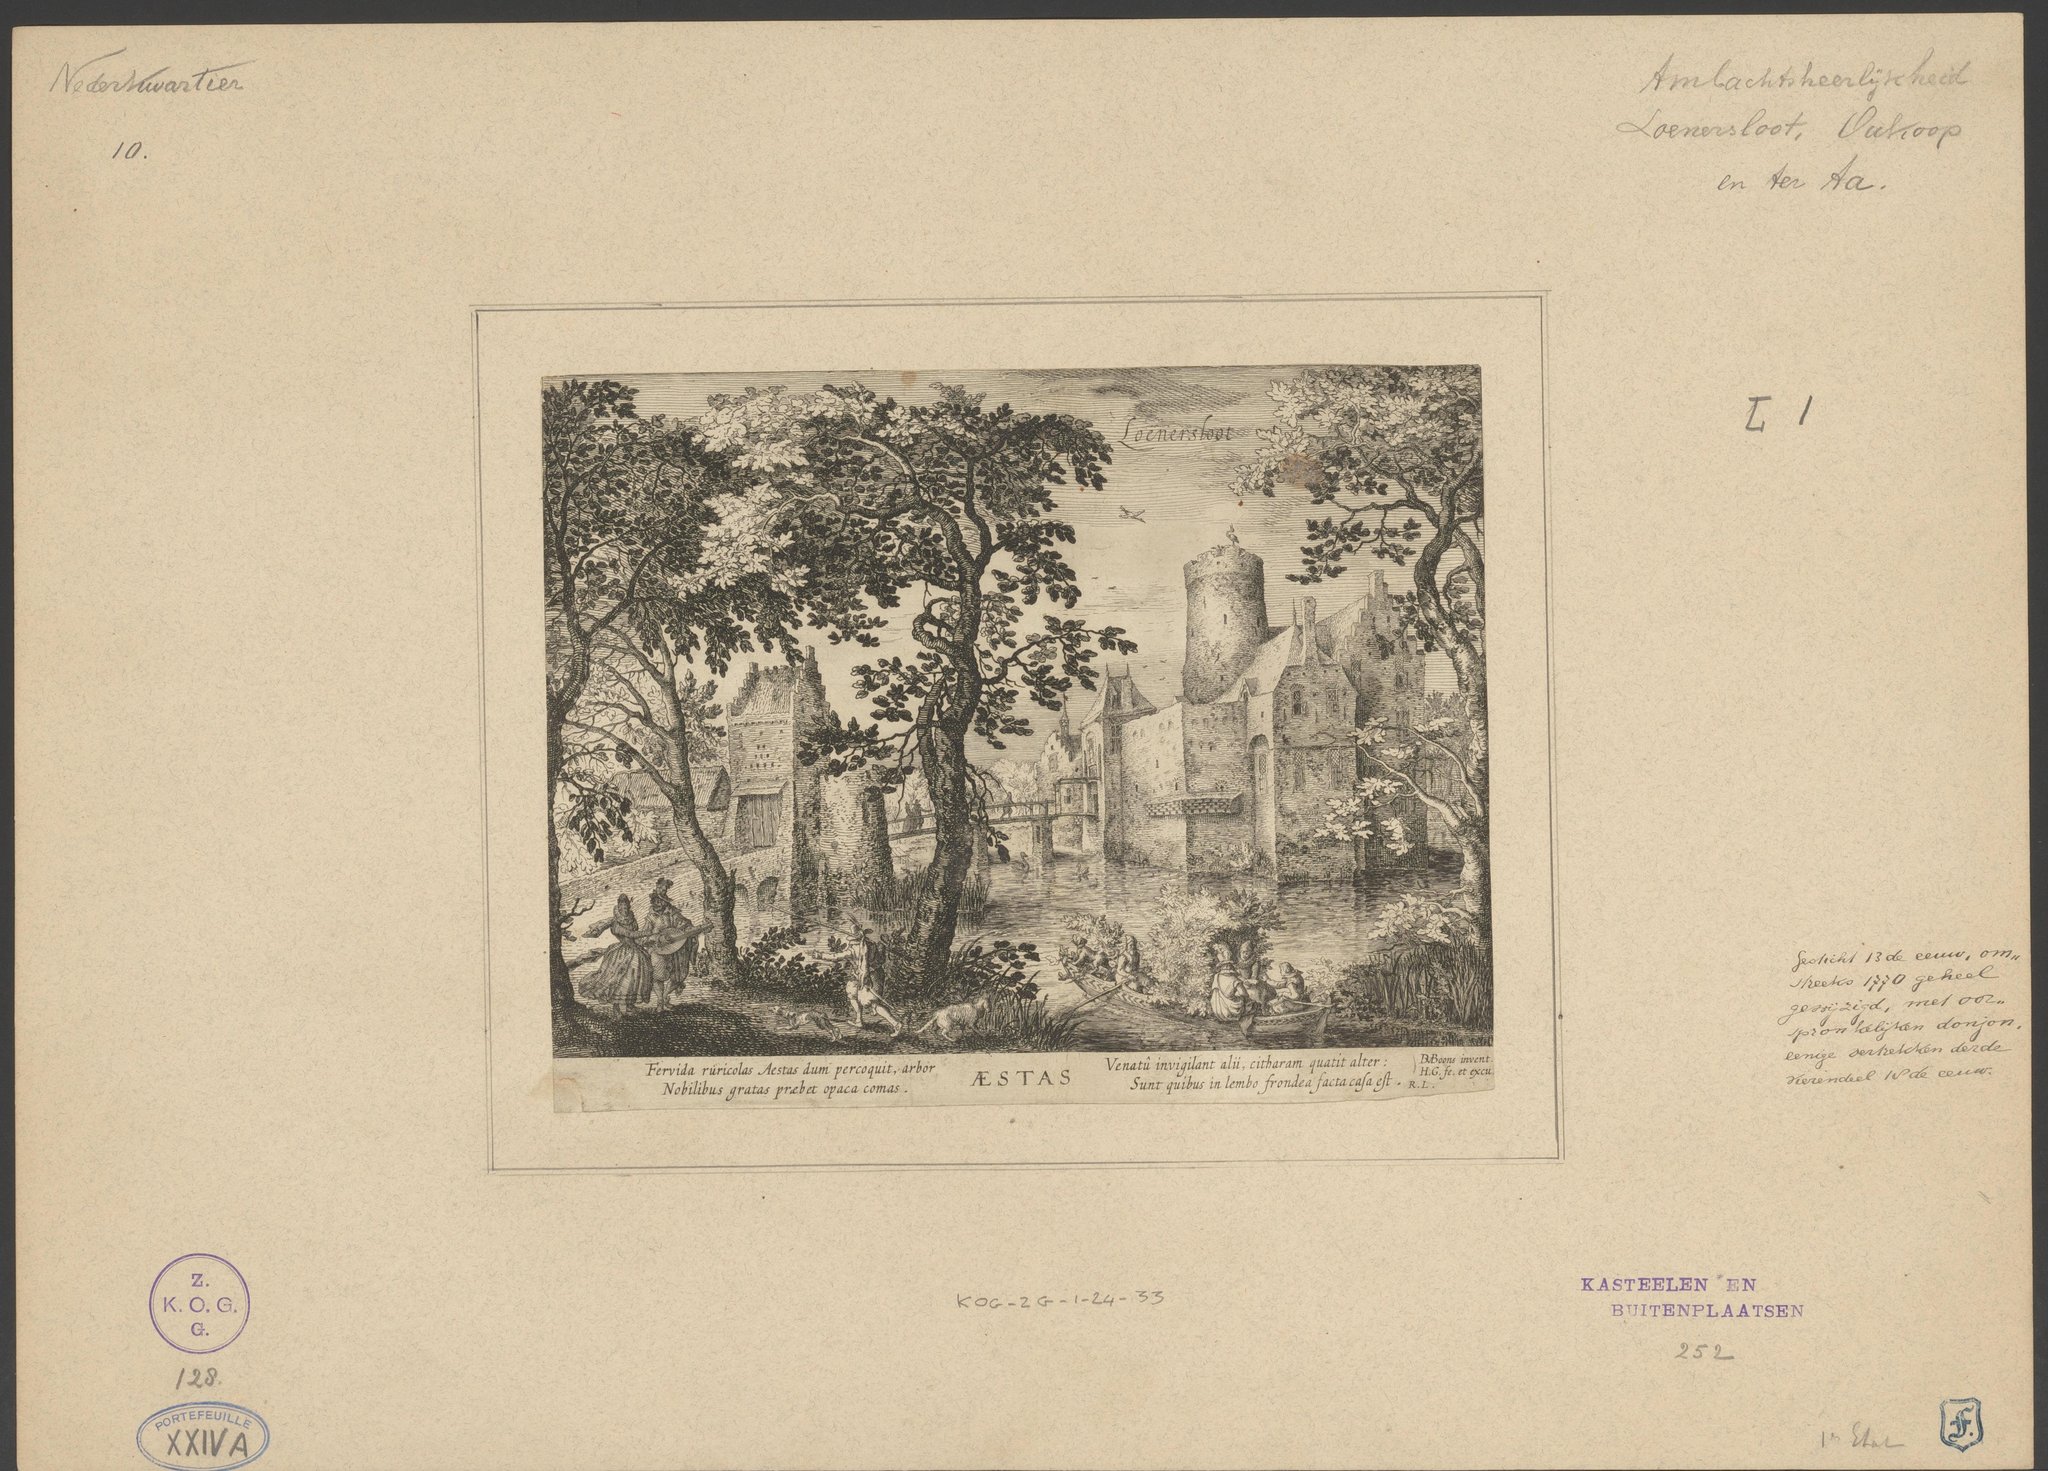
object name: print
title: Aestas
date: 1591-1632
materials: paper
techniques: etching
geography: amsterdam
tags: summer ~ human activities (the four seasons of the year), rowing-boat, canoe, etc.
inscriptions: stamp:, collector's mark: Lugt 1641, stamp:, collector's mark: Lugt 963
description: Het seizoen zomer. Een elegant gezelschap vermaakt zich in een bootje en met muziek bij kasteel Loenersloot. Met onderschrift van vier regels in het Latijn. Onderwerpsrubrieken binnen de Atlas Zeden en Gewoonten: Zeden en Gewoonten in Engeren Zin, De Woning. Kastelen en buitenplaatsen. Utrecht (vervolg.).